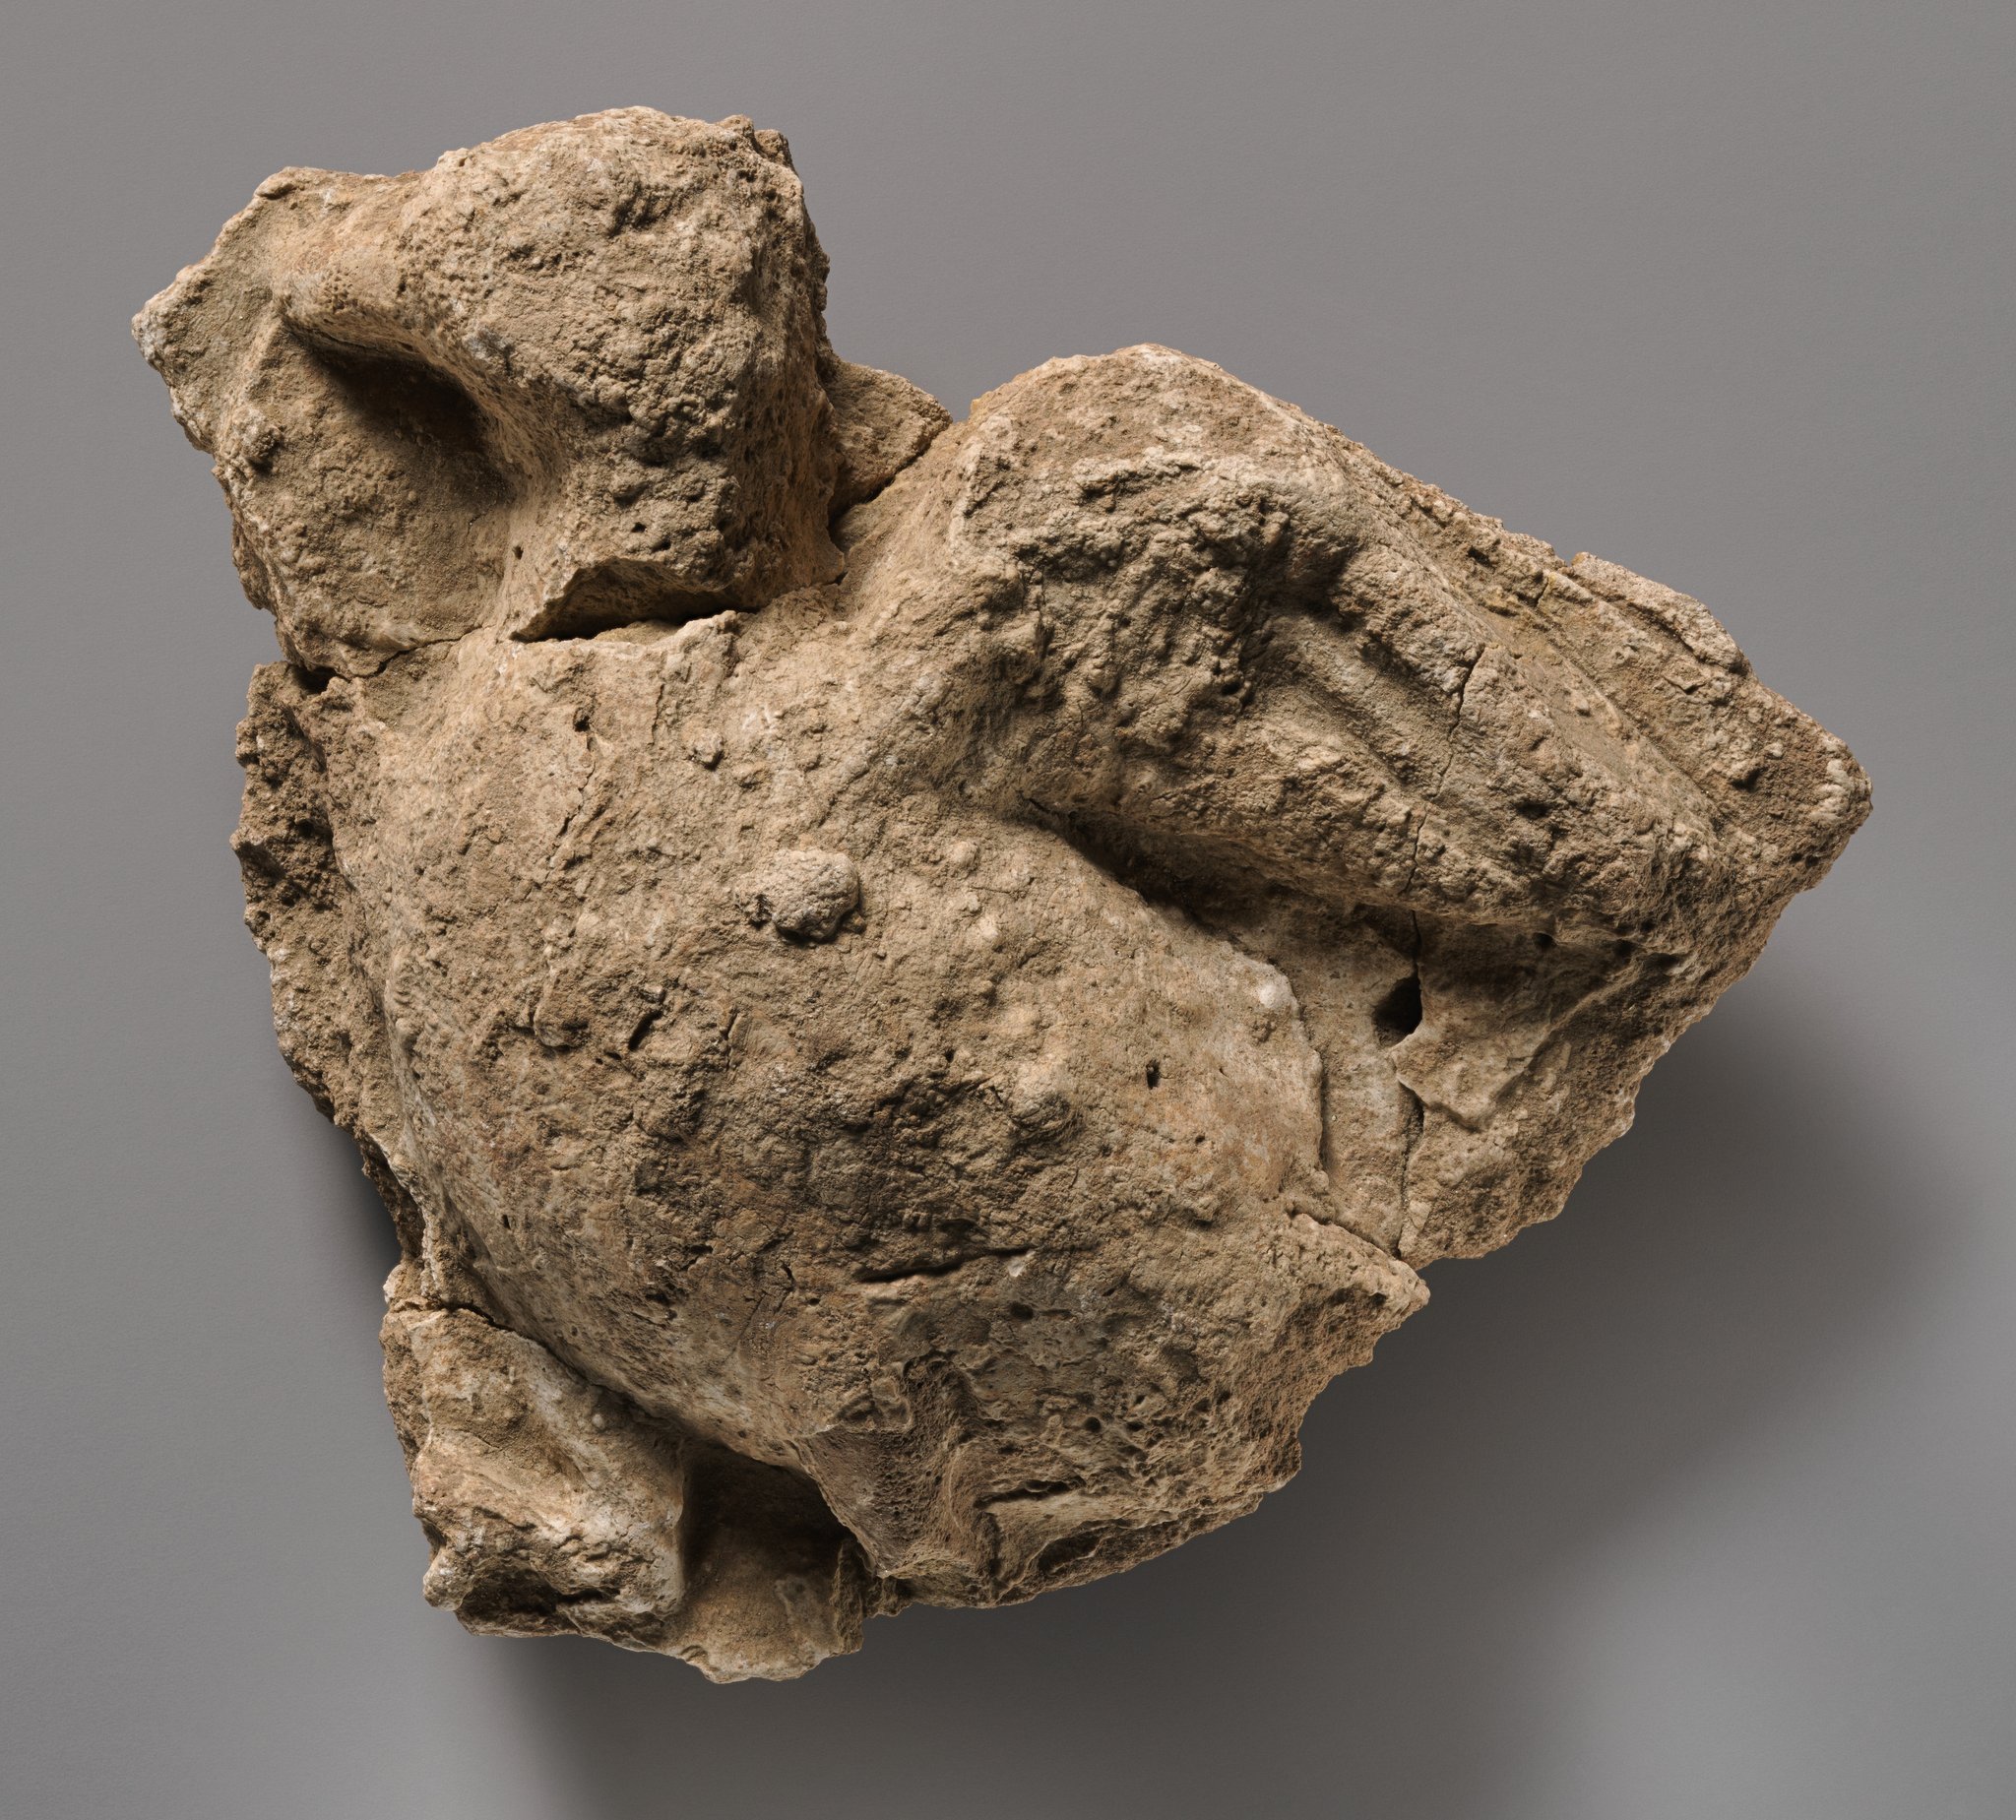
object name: relief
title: Fragment of a wall decoration with a flying bird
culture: sasanian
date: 501-600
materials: plaster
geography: mesopotamia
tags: birds